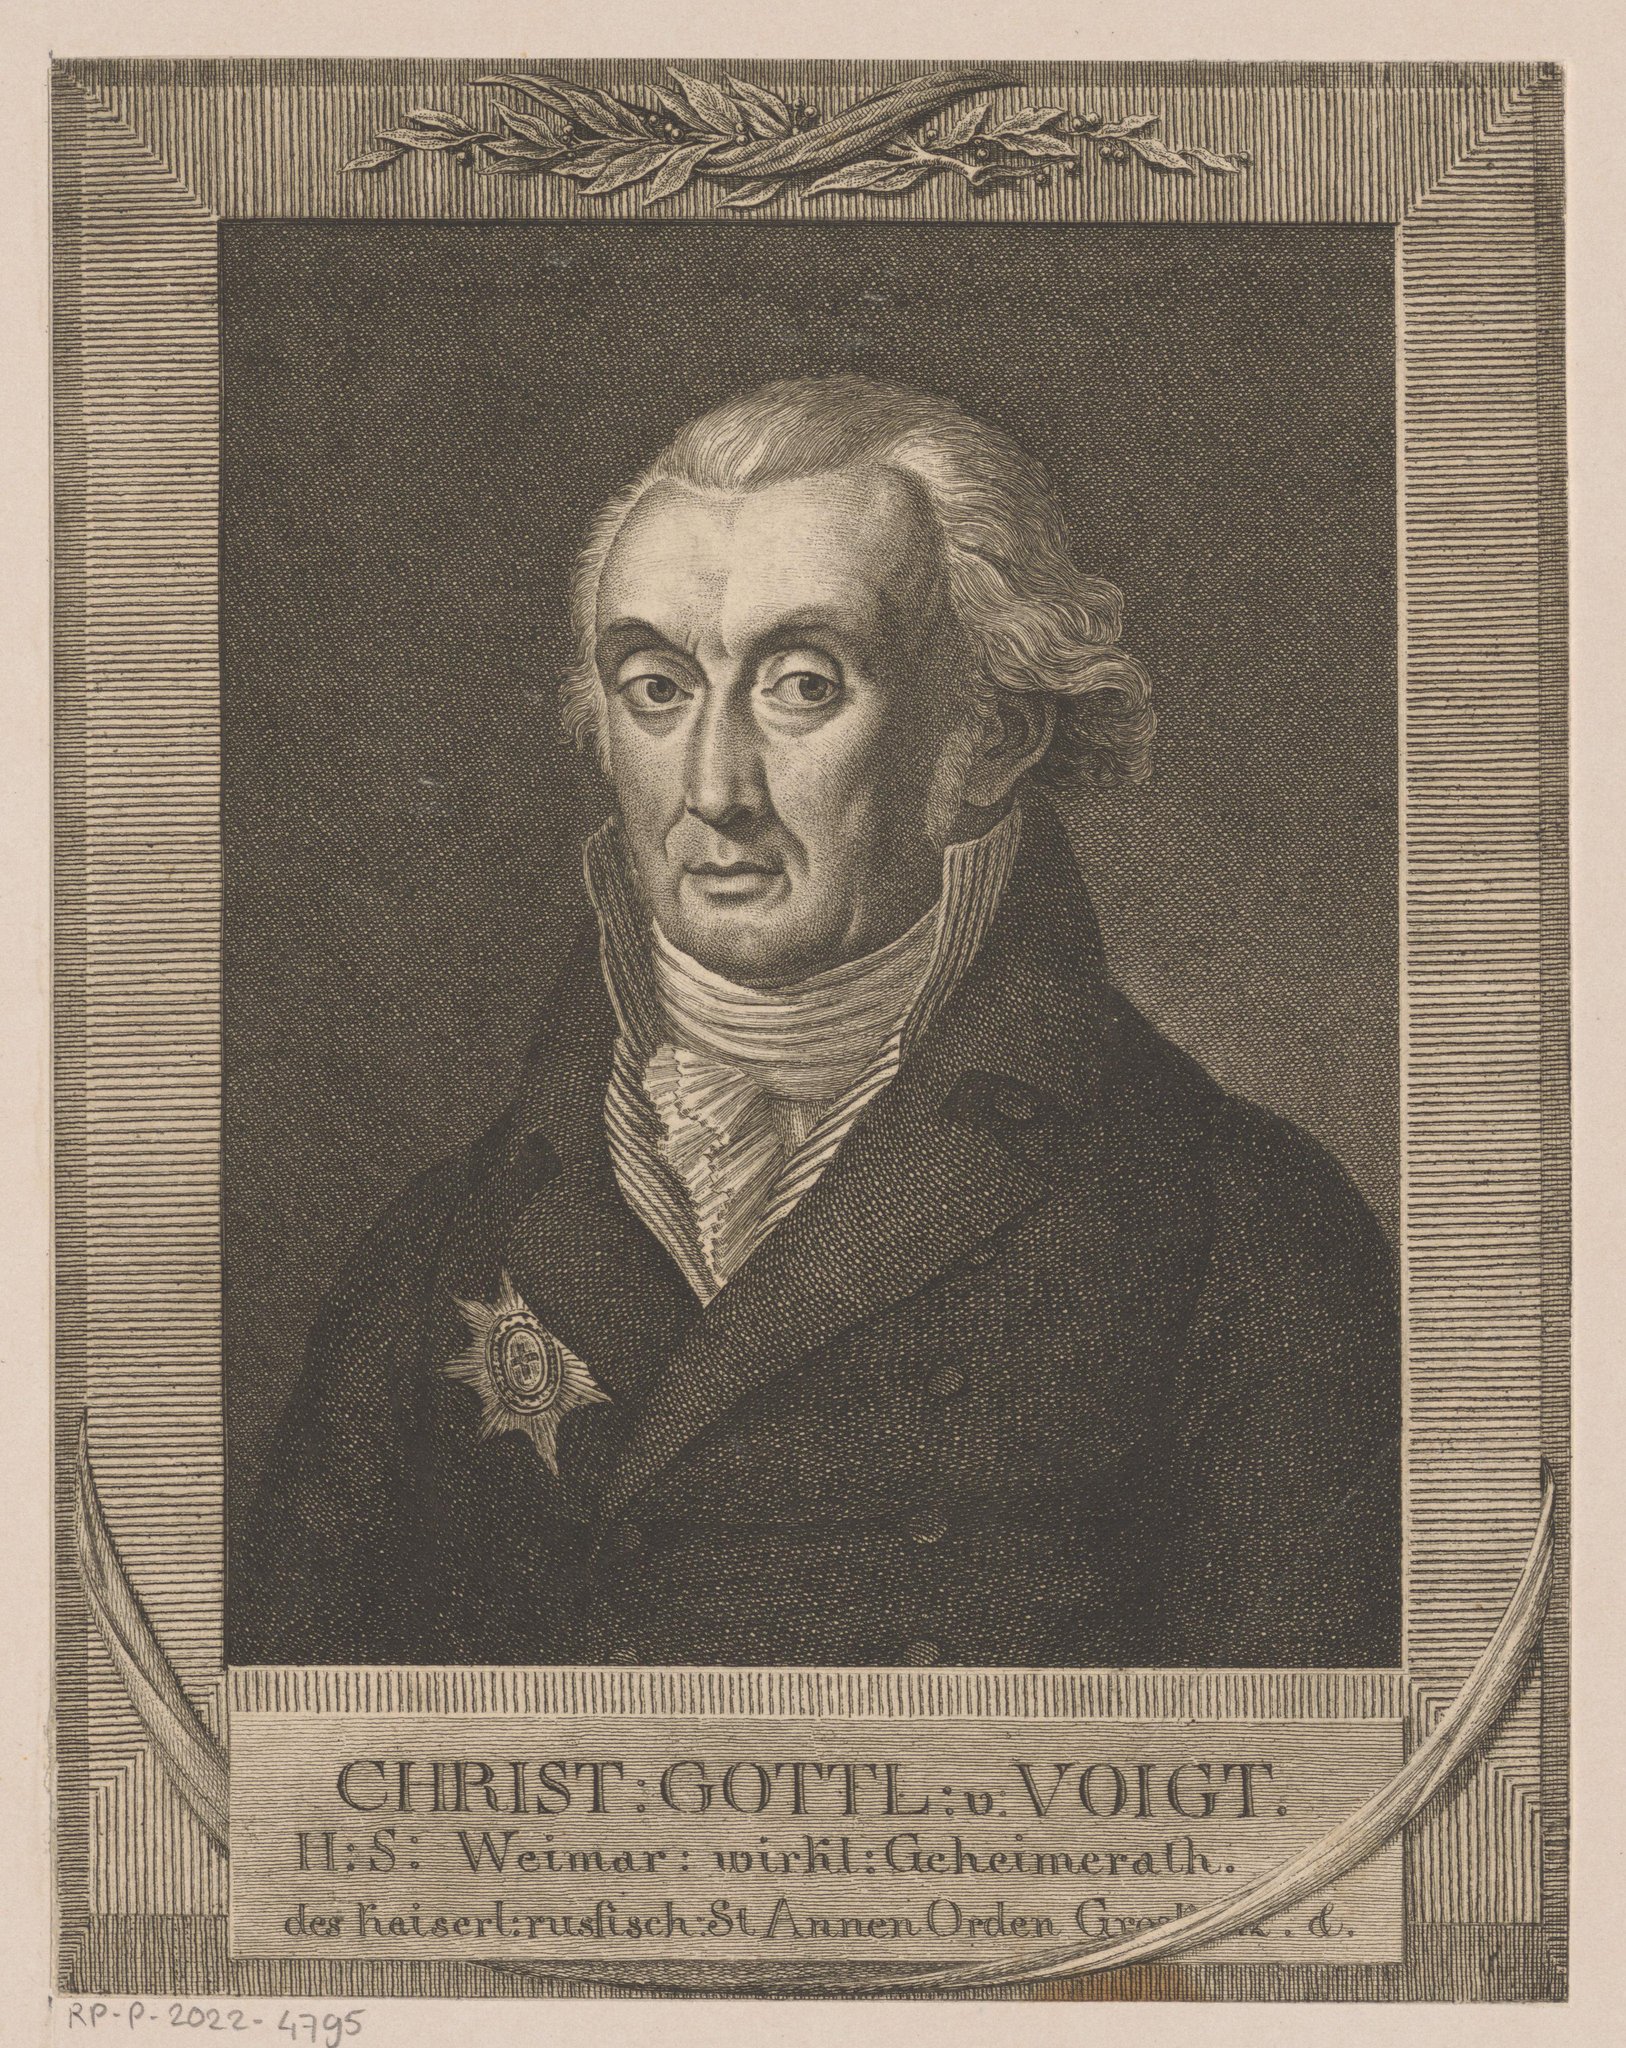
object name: print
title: Portret van Christian Gottlob von Voigt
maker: Anonymous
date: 1794-1825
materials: paper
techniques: etching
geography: germany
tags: politician, historical persons, politician, e.g. party leader